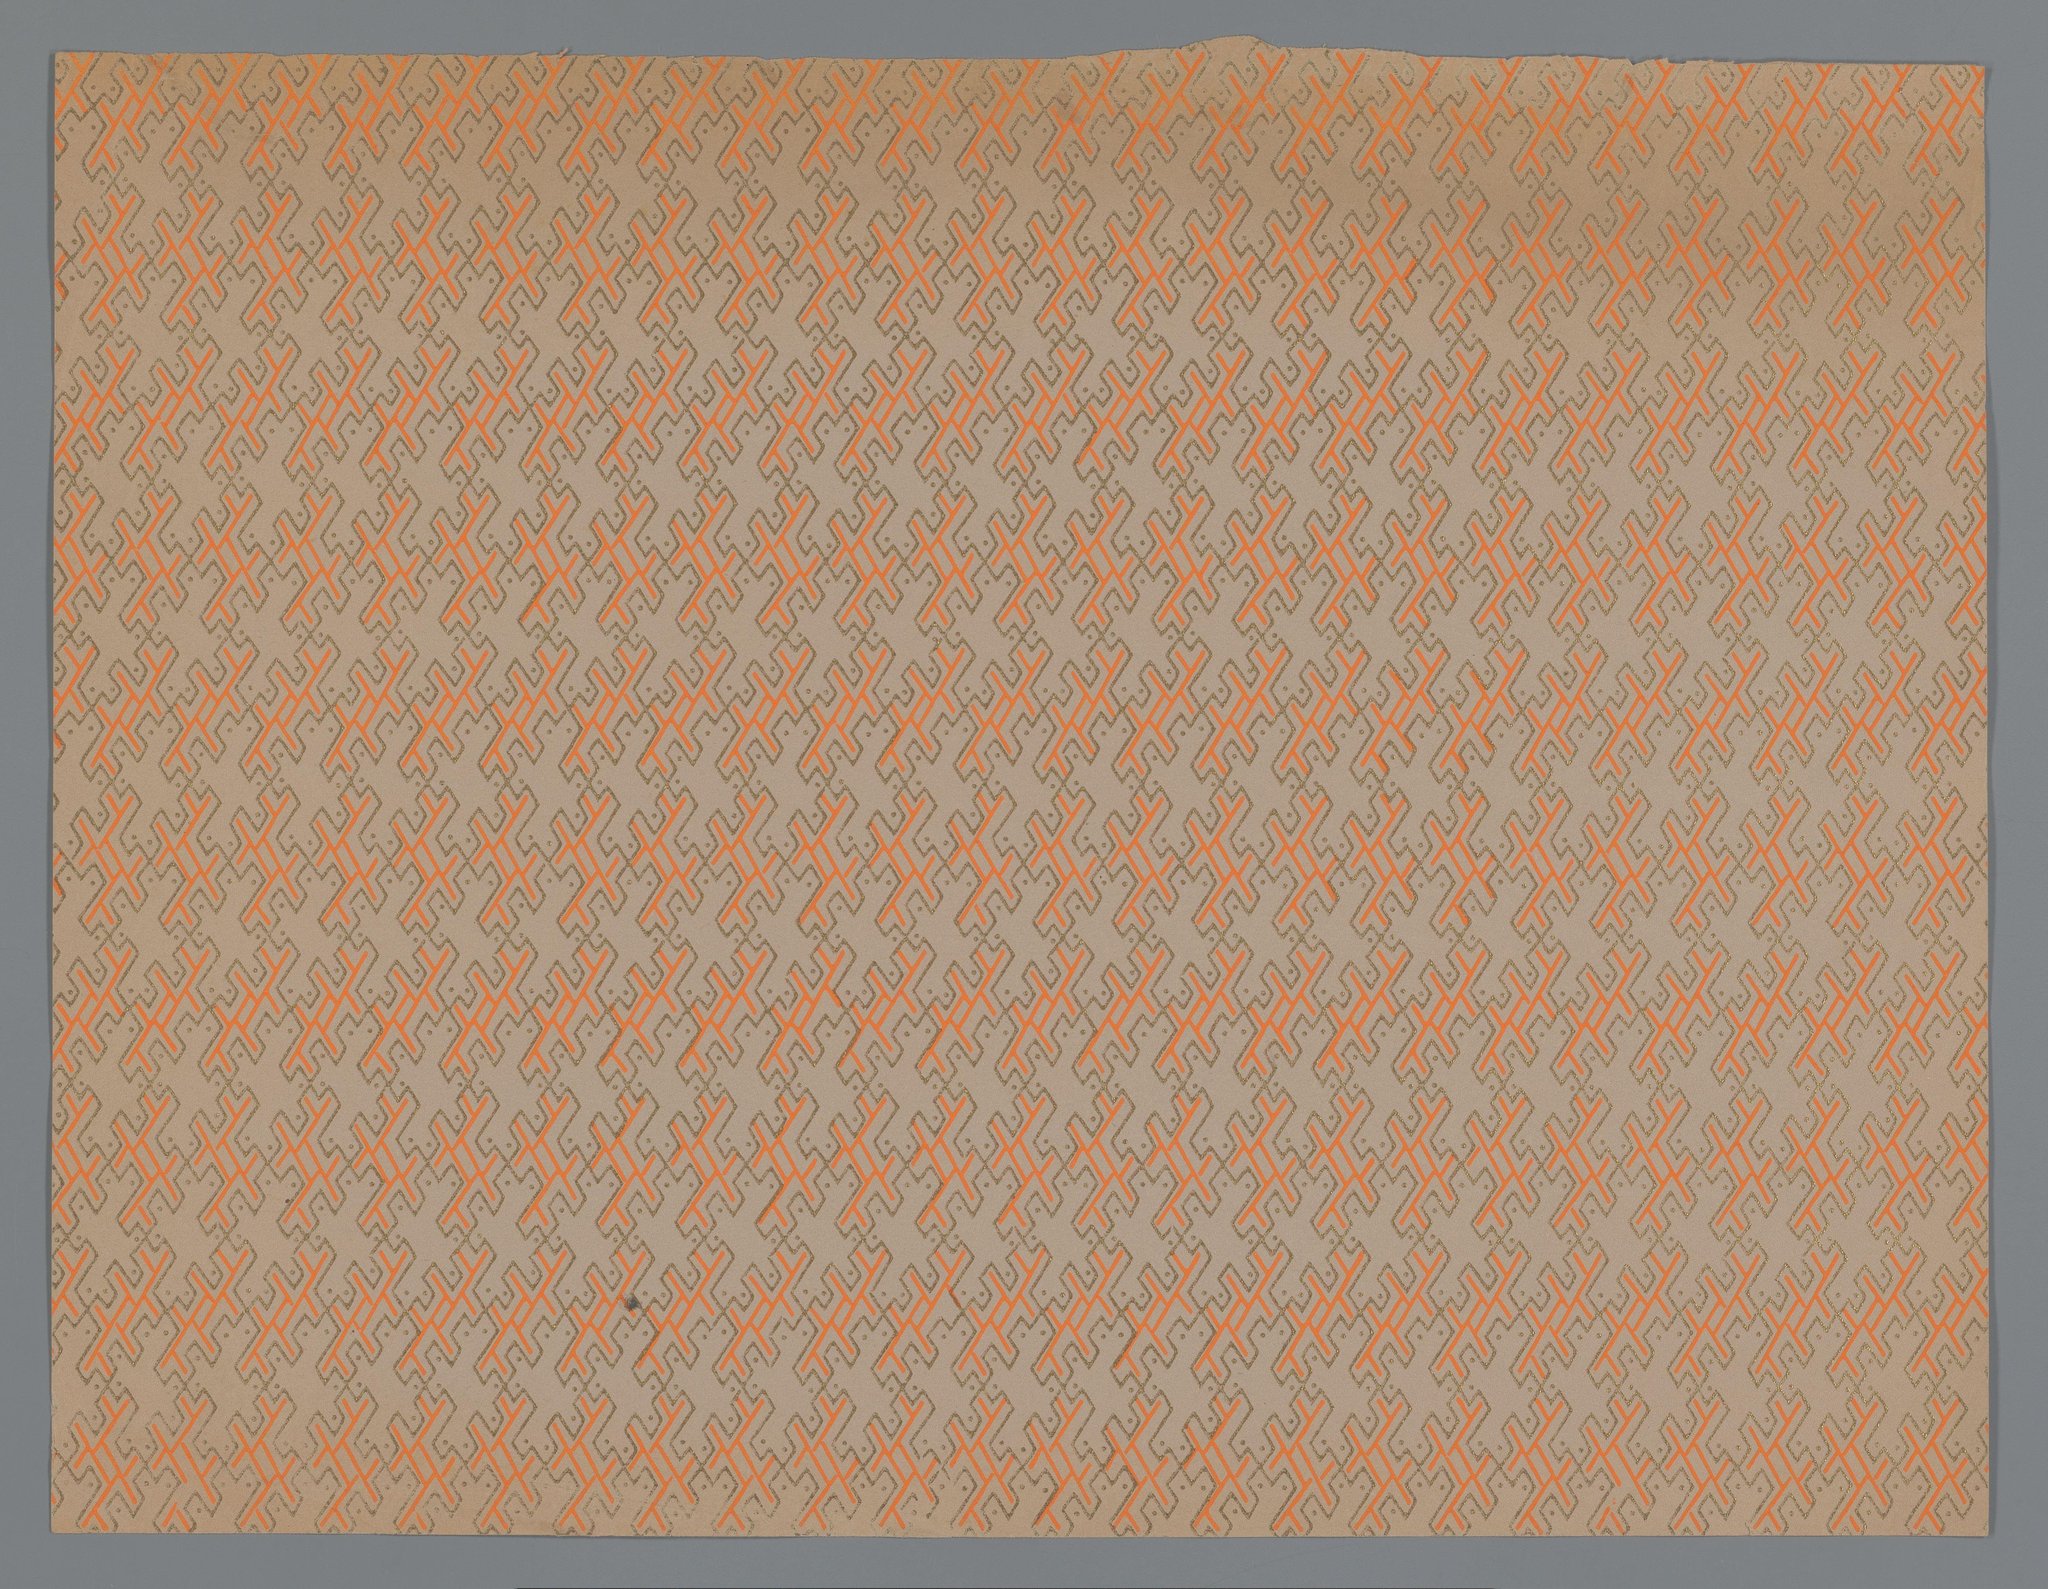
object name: decorated paper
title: Blad met geometrisch fantasiepatroon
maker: Anonymous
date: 1900-1970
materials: paint, paper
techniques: gauffering, mechanical printing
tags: ornament ~ geometric motifs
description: Blad met geometrisch fantasiepatroon in oranje en goud op gegaufreerd bruin papier.